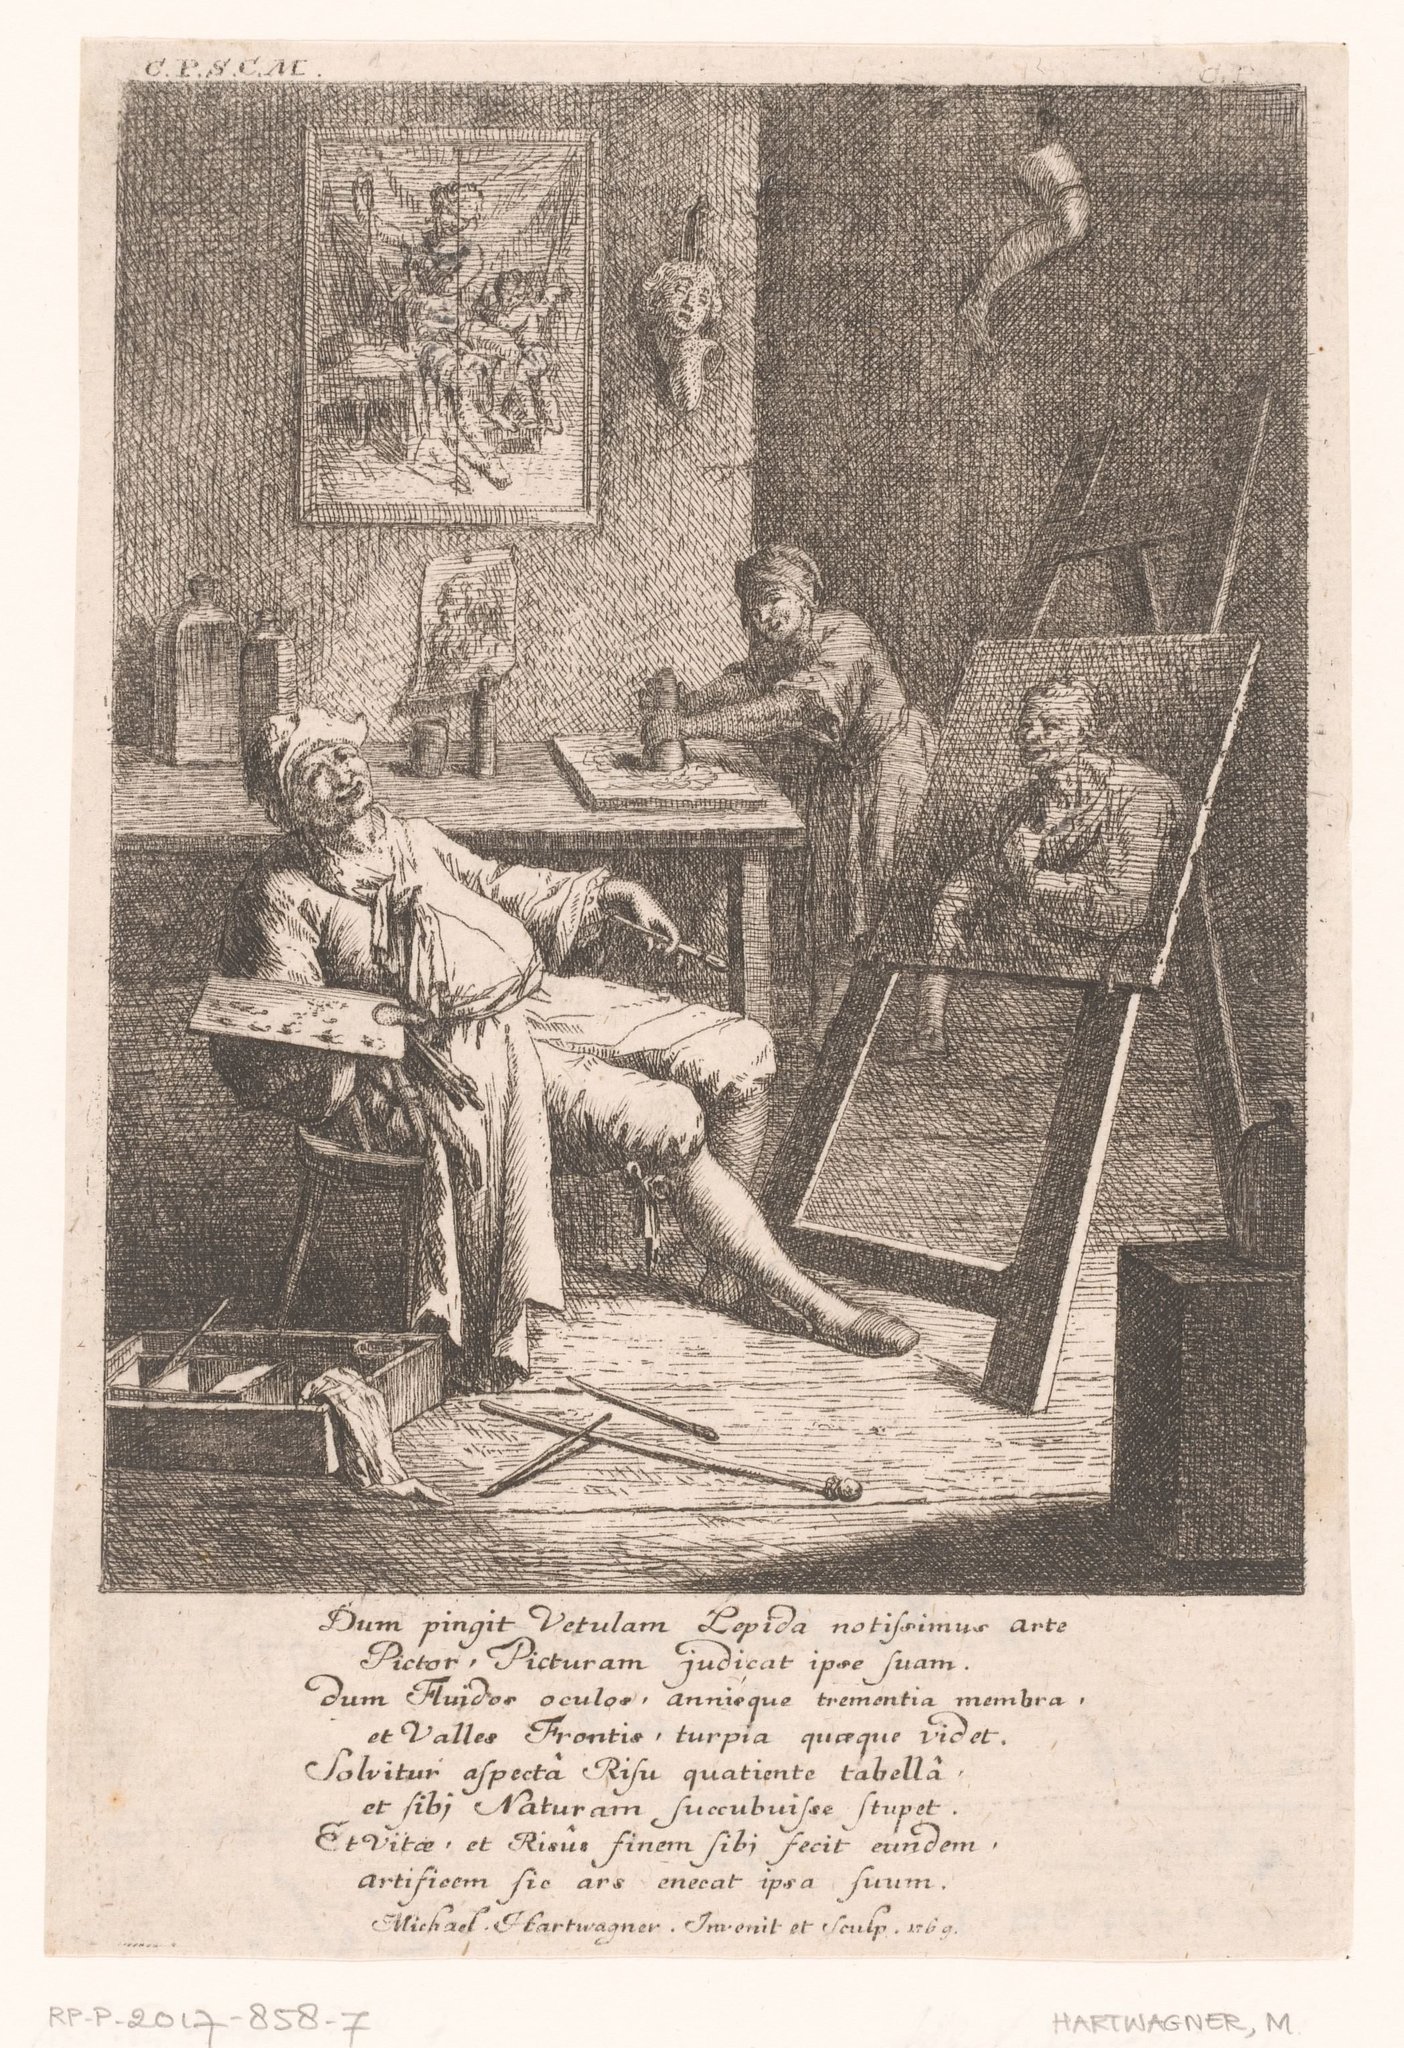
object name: print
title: Schilder in zijn atelier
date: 1769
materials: paper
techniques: etching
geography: germany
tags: (story of) the painter zeuxis, workshop, studio ~ painter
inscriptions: collector's mark: ‘L.A. DE VRIES’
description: Een schilder in zijn atelier, als lachende Zeuxis voor een schilderij van een oude vrouw. Op de achtergrond wrijft een leerling pigment. Onderaan een achtregelig vers in het Latijn.